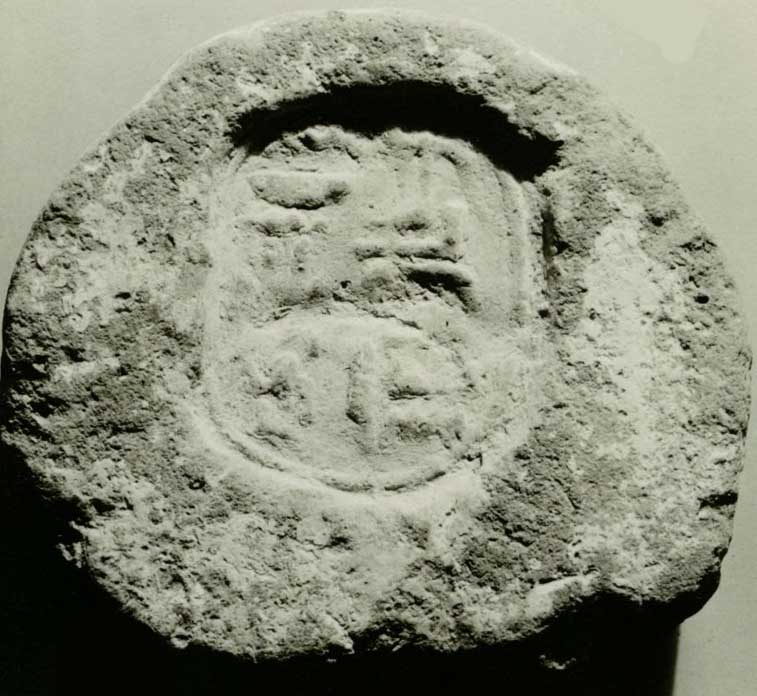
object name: cone, nebseny, oval impression, goldsmith of amun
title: Funerary Cone of the Goldsmith Nebseny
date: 1550-1295 BCE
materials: pottery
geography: egypt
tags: hieroglyphs